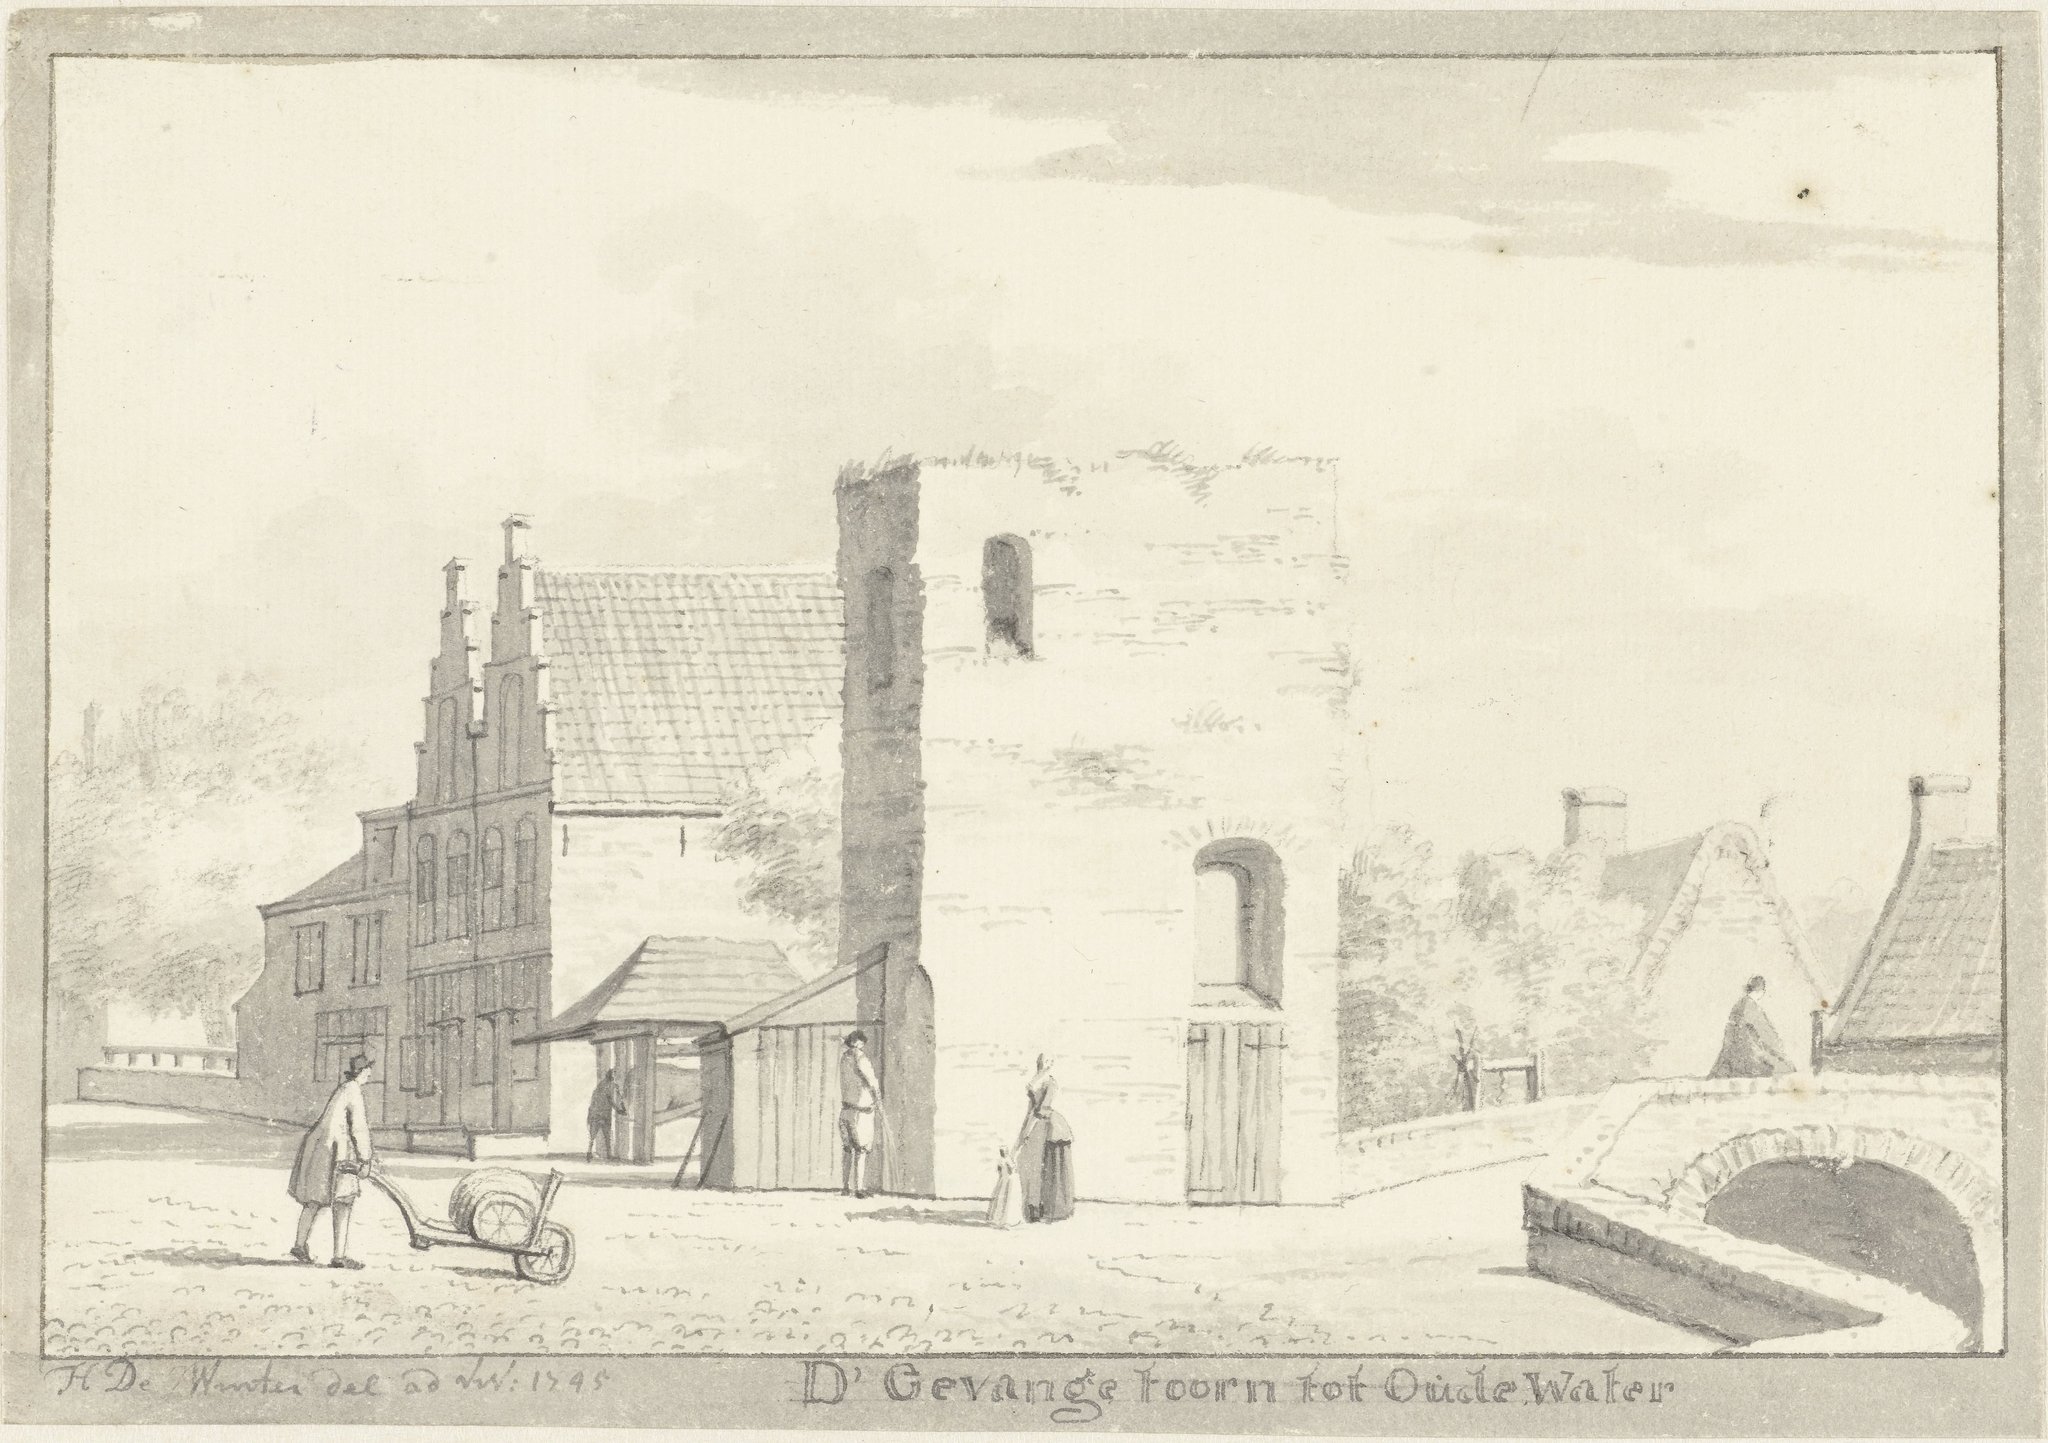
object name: drawing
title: D' Gevange toorn tot Oudewater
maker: hendrik de winter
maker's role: draughtsman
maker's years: 1717-1790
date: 1745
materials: ink, paper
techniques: brush, pen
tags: prison, jail, street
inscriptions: inscription: ‘Opschrift: H de Winter del ad viv: 1745 D'Gevange toorn tot OudeWater’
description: Voor prent gebaseerd op deze tekening zie RP-P-AO-10-65A-5.